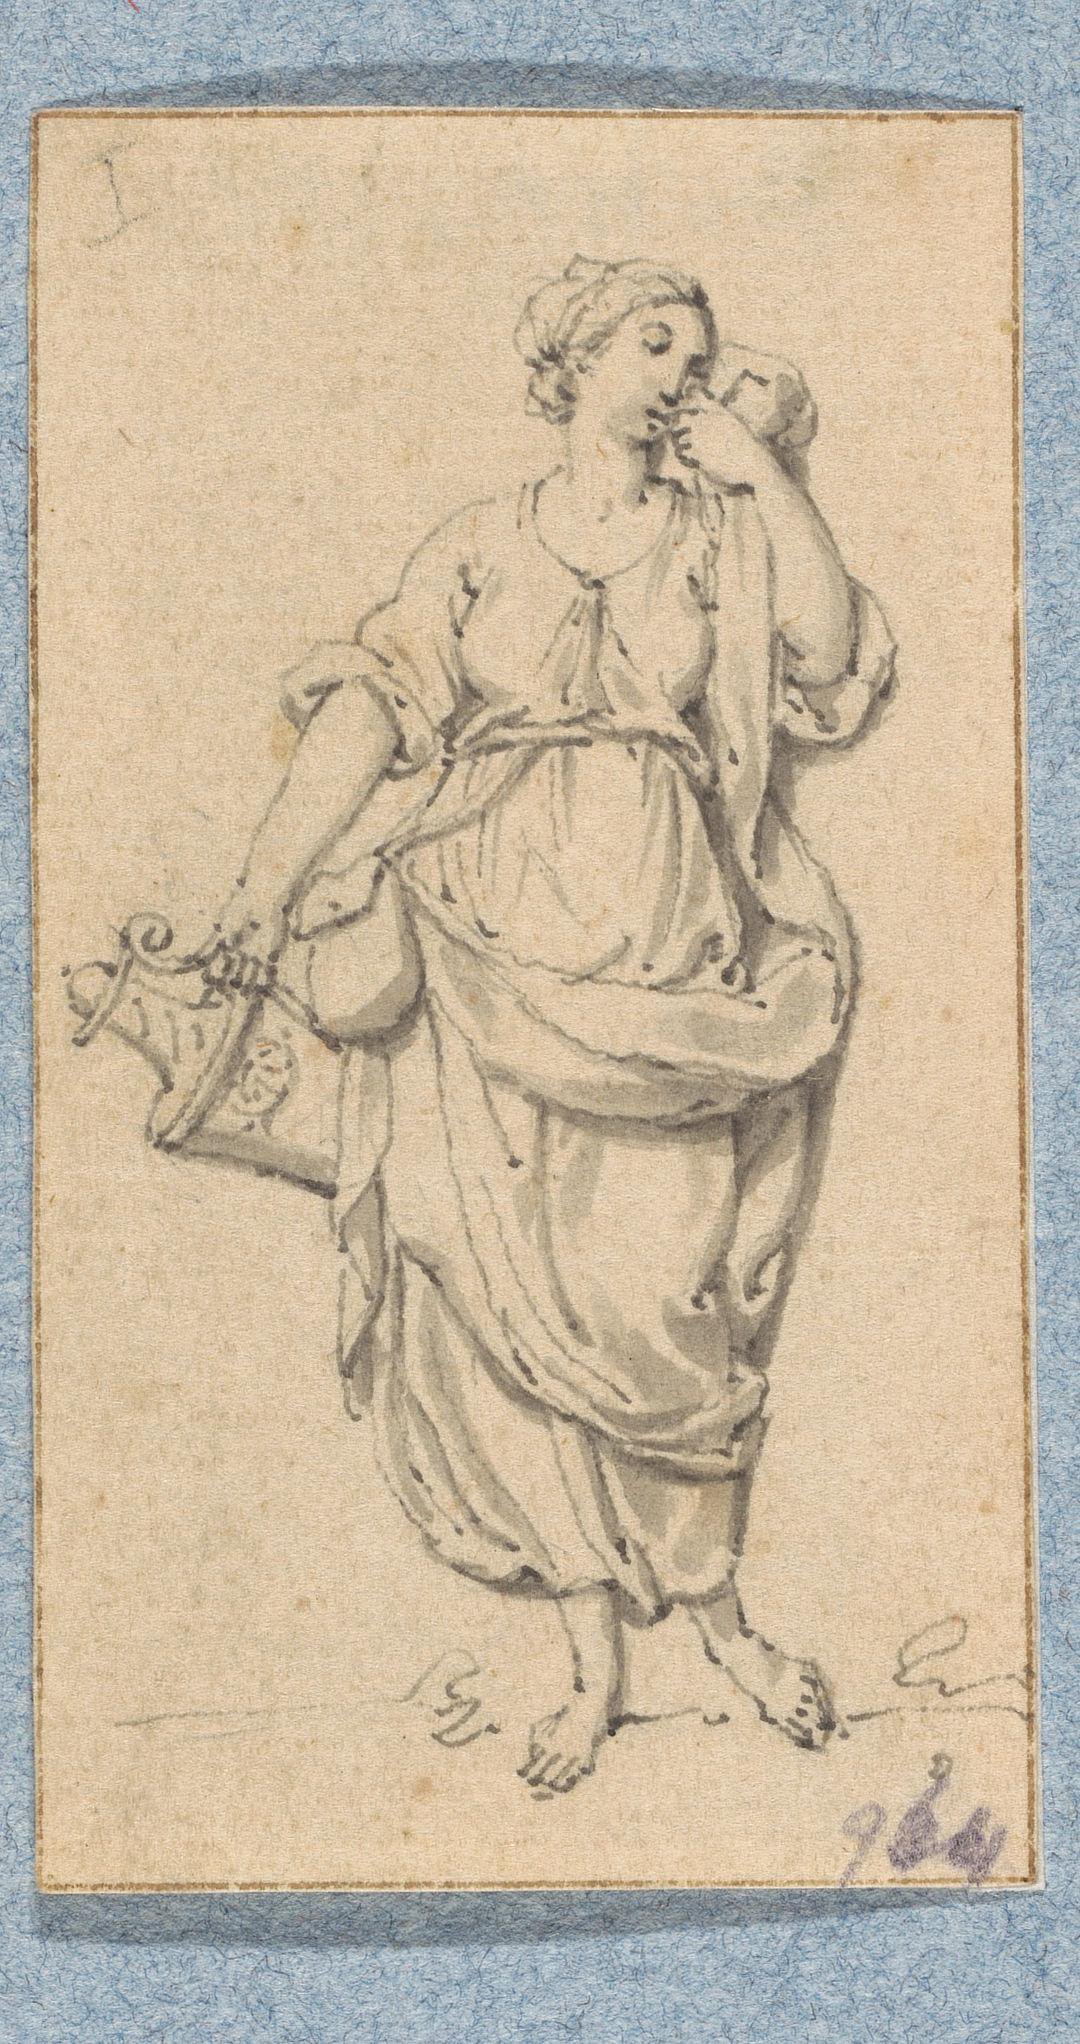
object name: drawing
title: Staande vrouw met vaas (in doos met 43 tekeningen)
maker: louis fabritius dubourg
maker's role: draughtsman, print maker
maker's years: 1693-1775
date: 1703-1775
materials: ink, paper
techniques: brush, pen